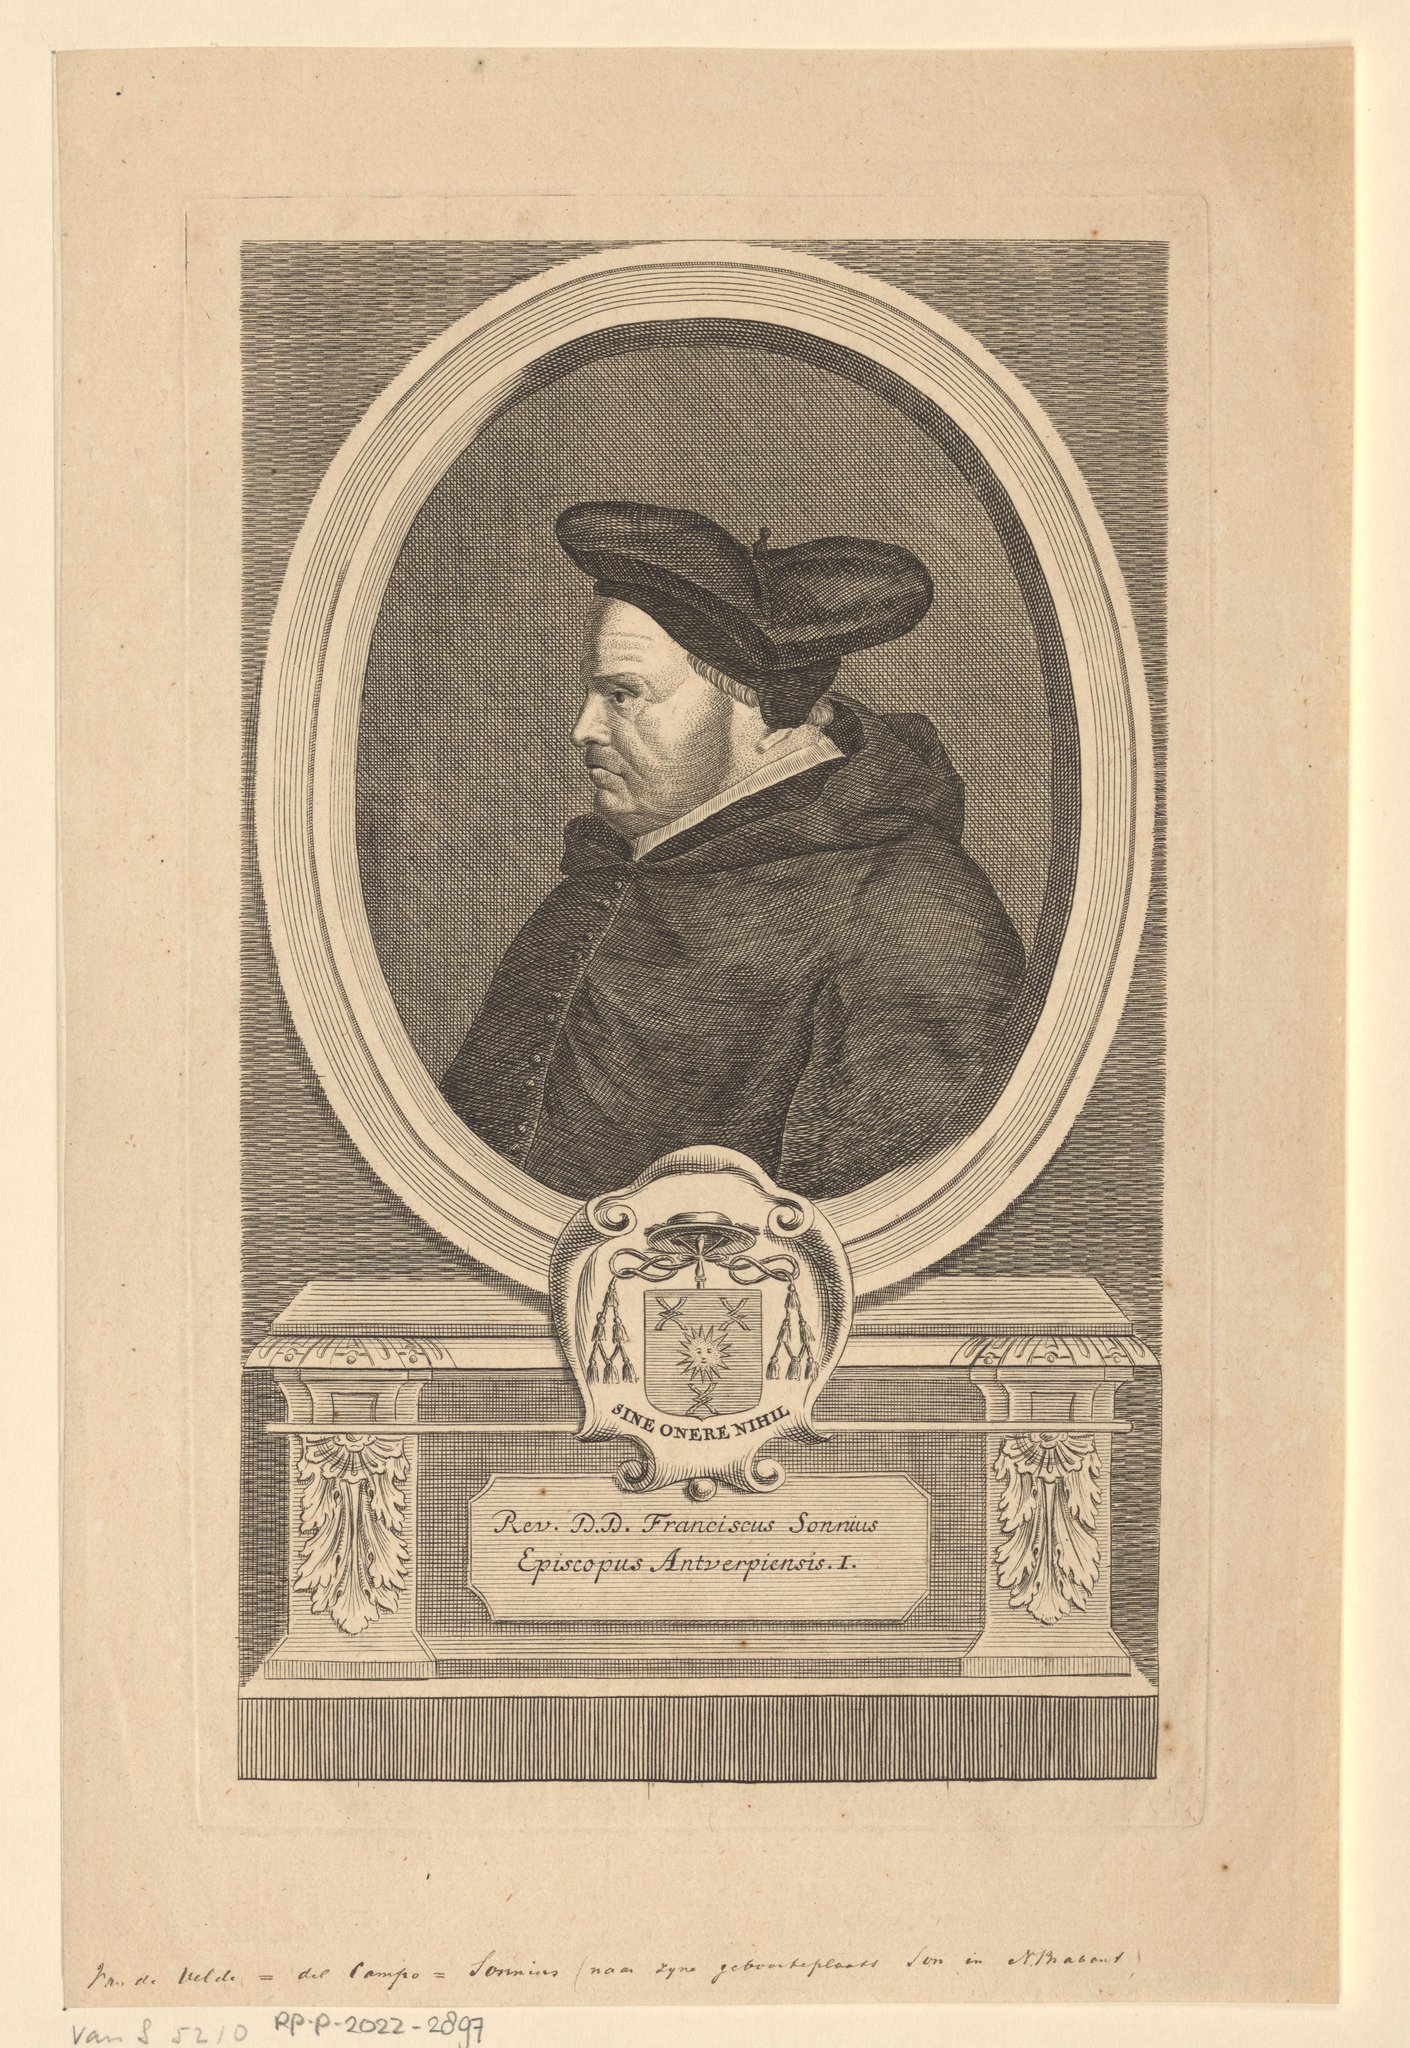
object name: print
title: Portret van Franciscus Sonnius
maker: jan baptist jongelinx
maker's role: print maker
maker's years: 1689-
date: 1727-1734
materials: paper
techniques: engraving, etching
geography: antwerp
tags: archbishop, bishop, etc. (roman catholic), theologian, historical persons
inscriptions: inscription: ‘Van de Velde = del Campo = Sonnius (naar zijn geboorteplaats Son in N Brabant)’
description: Prent met tekst in boekdruk op verso gebruikt in: Roy, Jacques le. Groot kerkelyk tooneel des Hertogdoms van Brabant. Den Haag: Christiaan van Lom, 1727. Prent mogelijk ook gebruikt in: Roy, Jacques le. Le grand theatre sacré du duché de Brabant. Den Haag: G. Block, 1734.